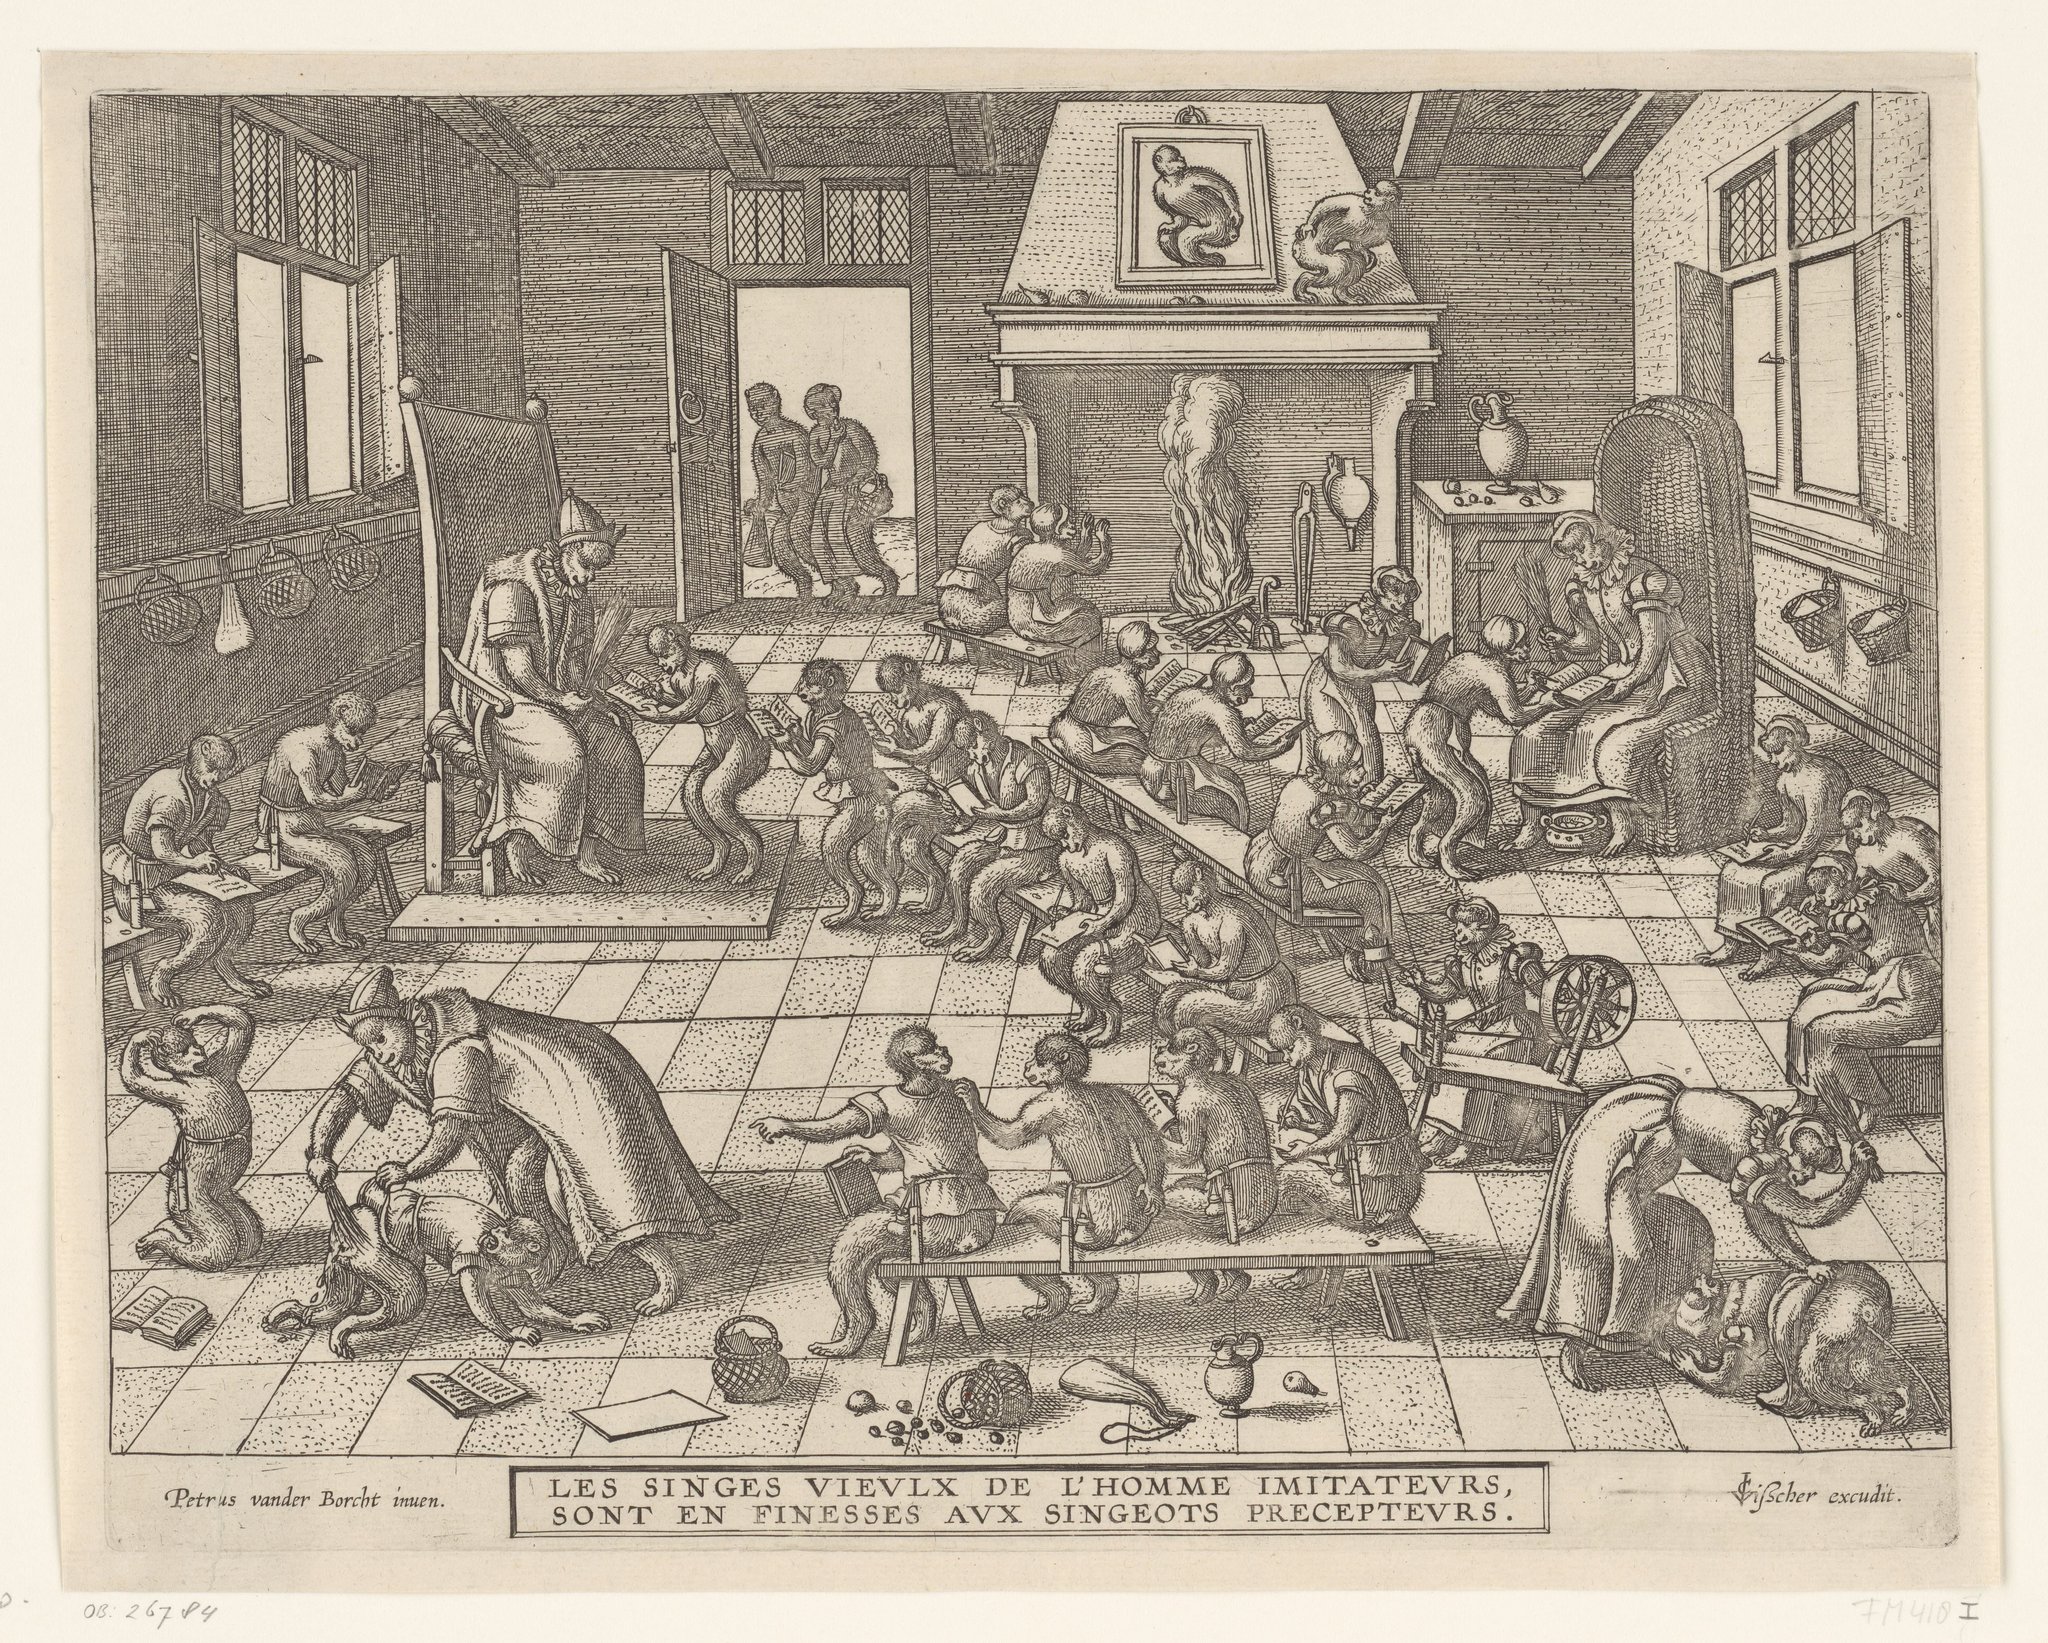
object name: print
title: Apenschool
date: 1597-1608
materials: paper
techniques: etching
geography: amsterdam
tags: monkeys, apes, 'mundus inversus', the reversed world, the topsy-turvy world, 'le monde bestourné', elementary school; class, form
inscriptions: collector's mark: Lugt 2228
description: Een 16de-eeuwse school. Schoollokaal met apen als meesters en leerlingen. Enkele apen worden met een roede gestraft, anderen lezen en schrijven gezeten op houten bankjes. Met onderschrift van 2 regels in het Latijn.